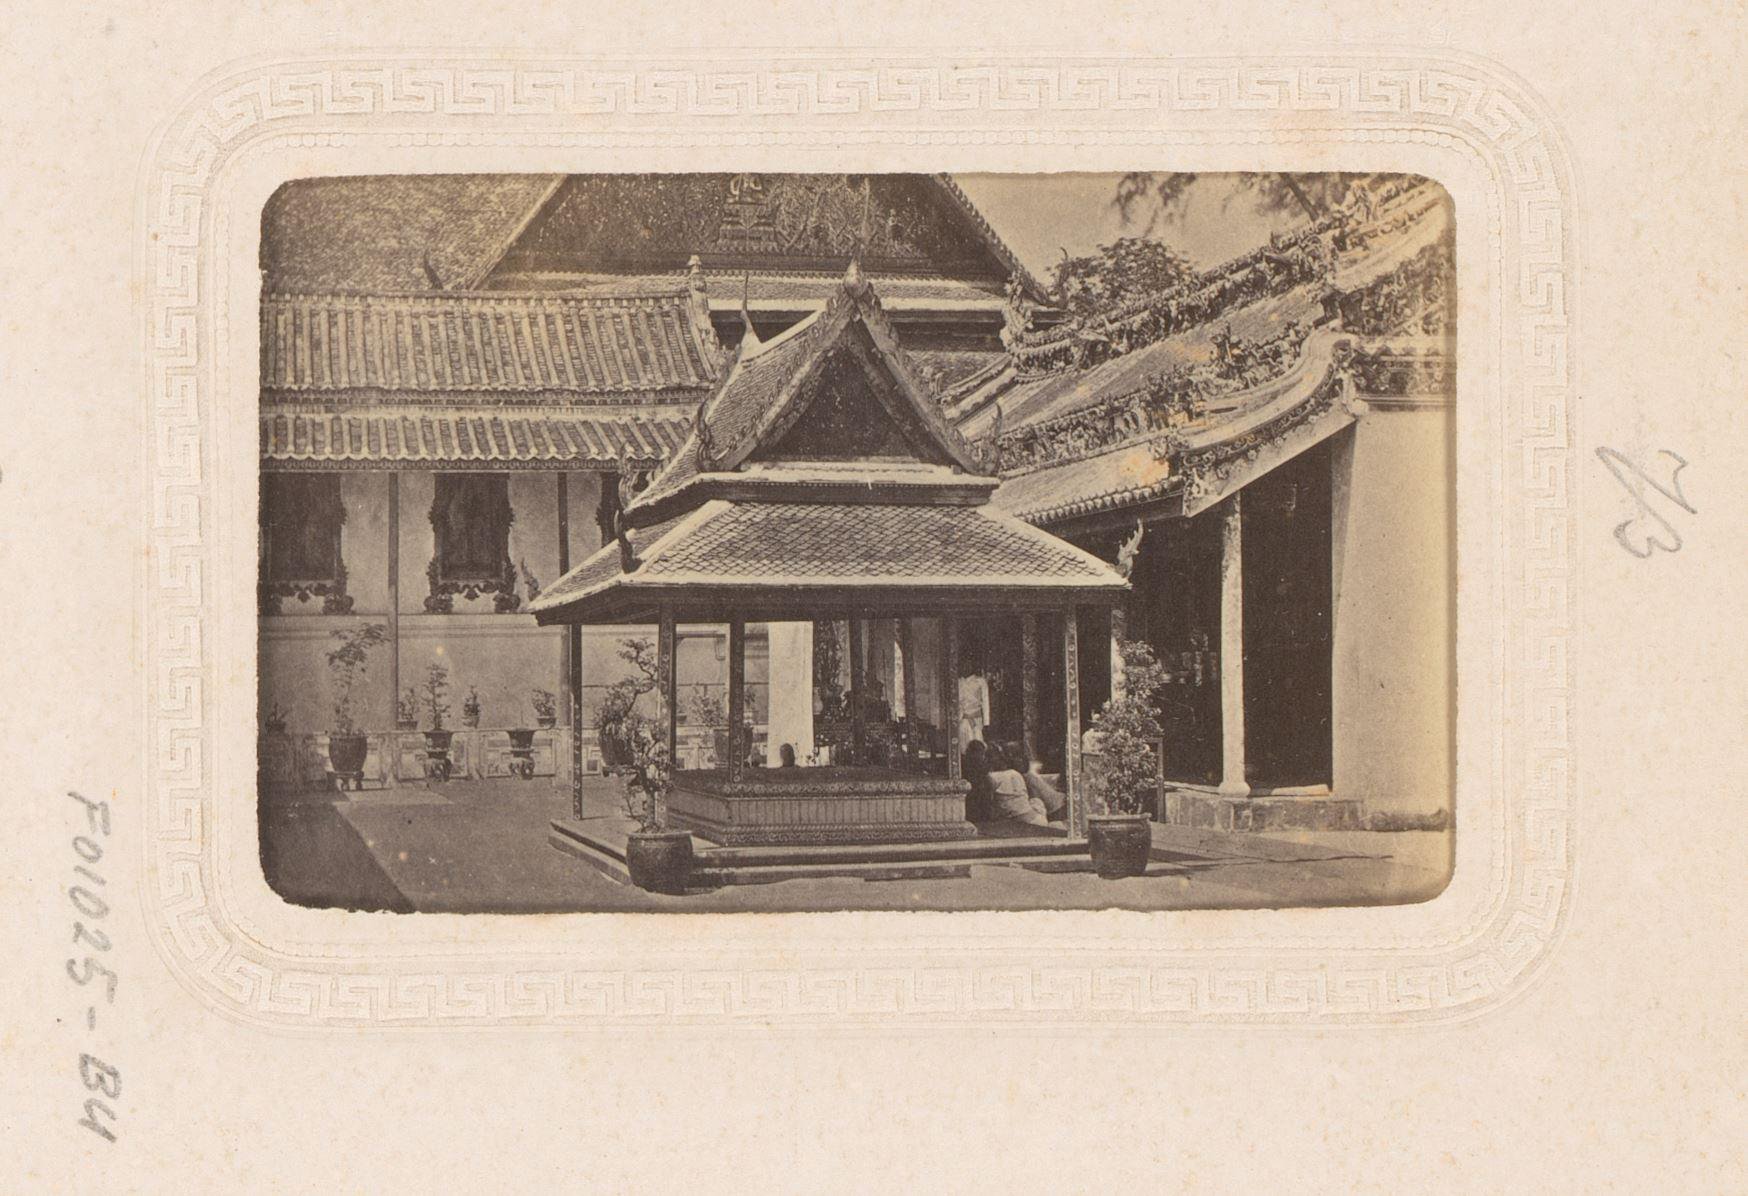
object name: photograph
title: Interieur van een Chinese kerk te Singapore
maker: Anonymous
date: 1850-1880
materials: cardboard, photographic support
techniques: albumen print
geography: singapore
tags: interior of church, singapore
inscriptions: annotation: ‘Chin: kerk van binnen/ Singapore’, number: ‘73’